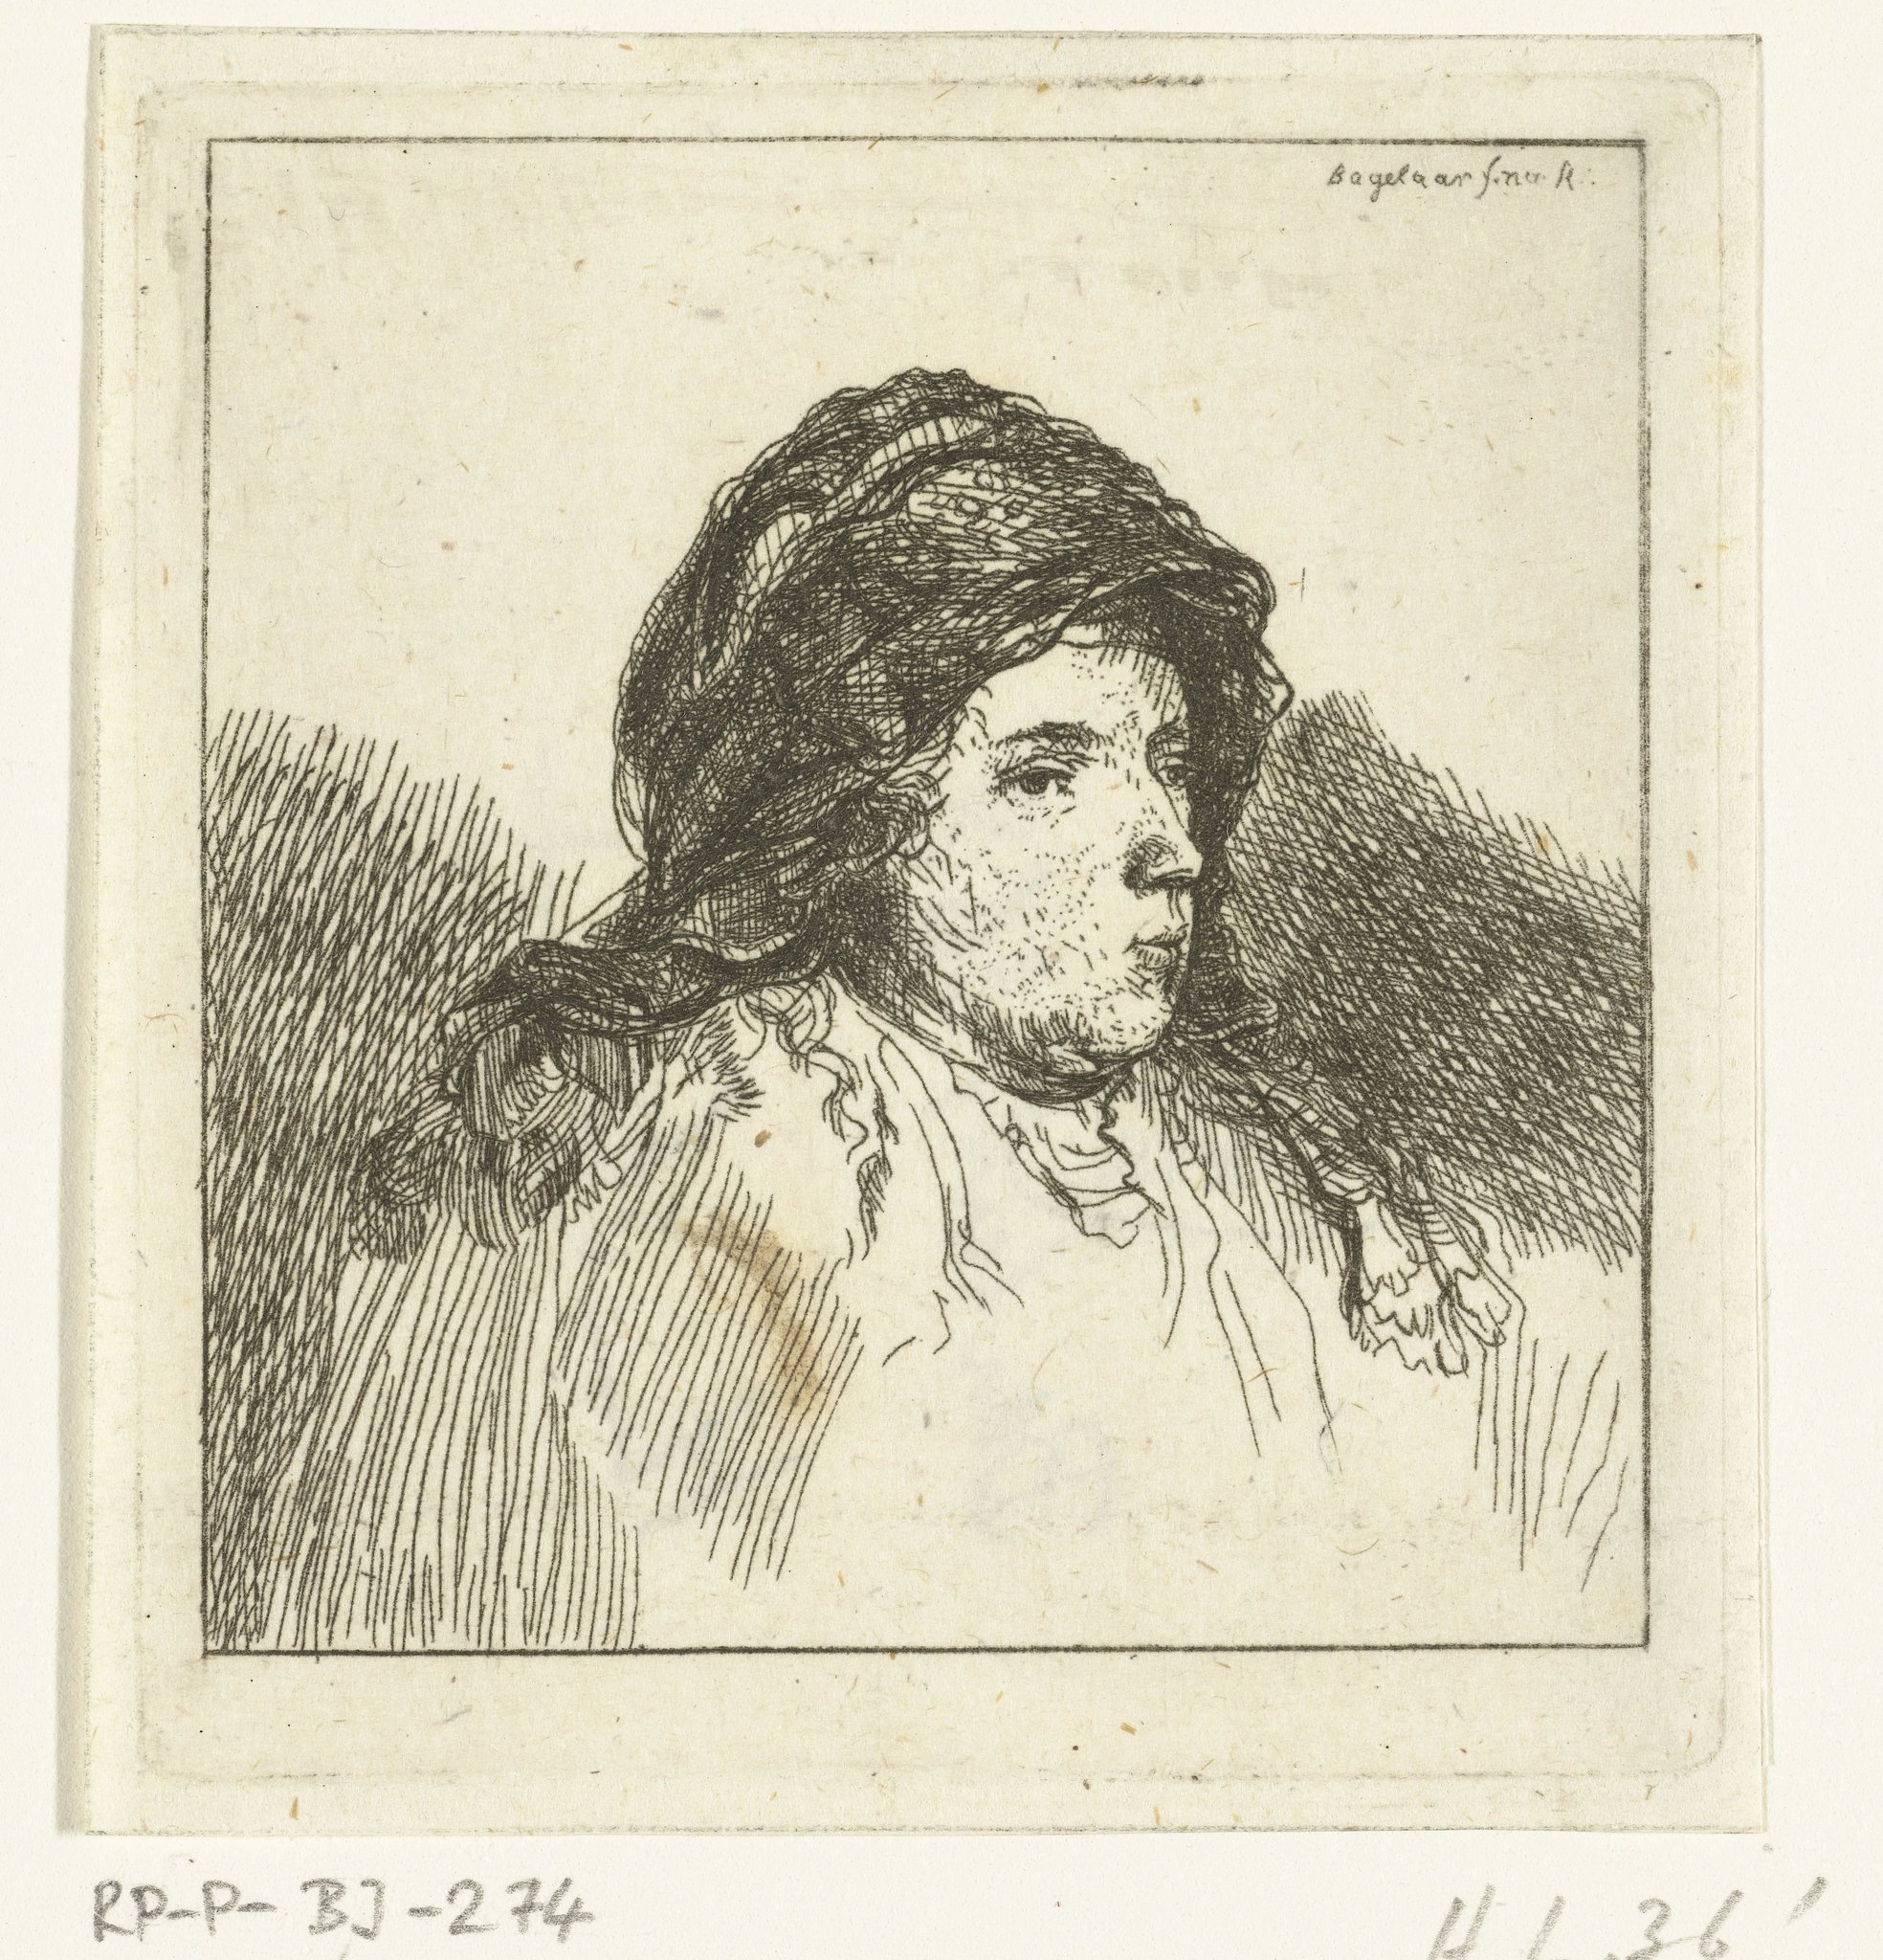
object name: print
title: Portretbuste van een vrouw met doek om haar hoofd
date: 1798-1837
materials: paper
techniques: etching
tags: adolescent, young woman, maiden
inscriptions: collector's mark: Lugt 2228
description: kopie in spiegelbeeld naar Rembrandt: Bartsch 368